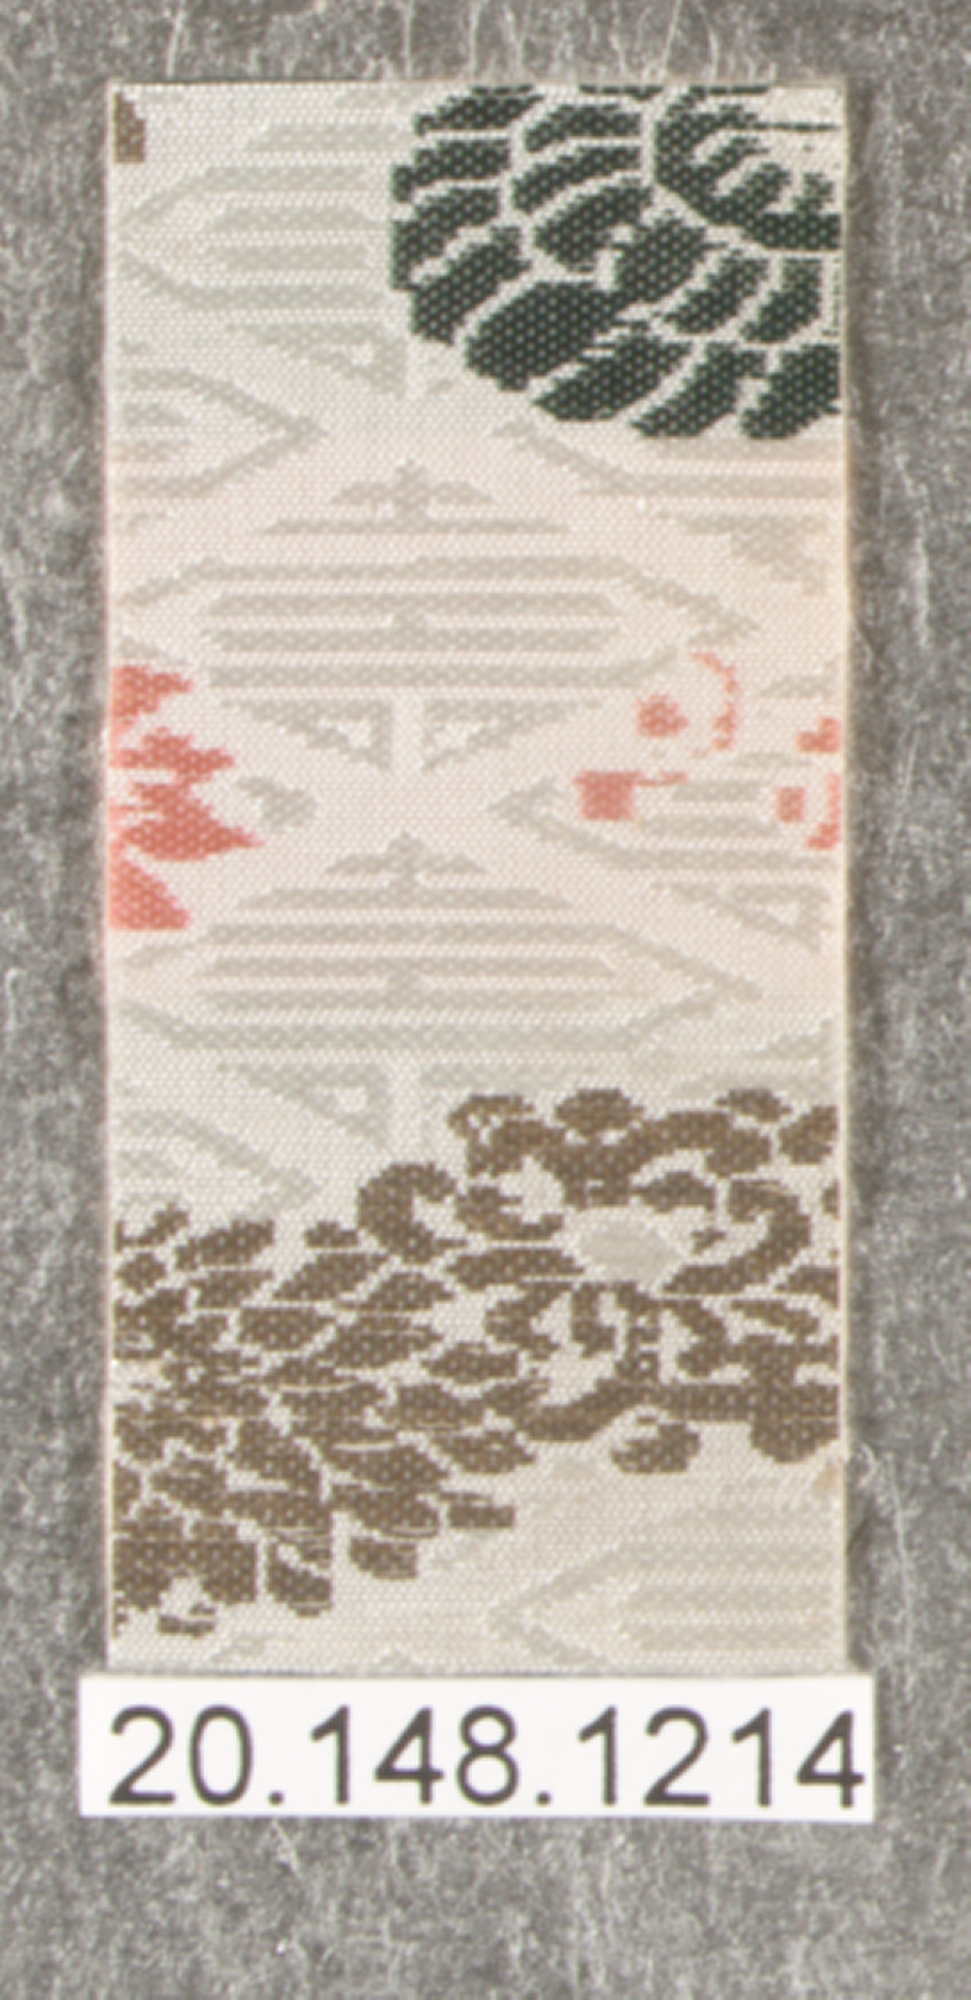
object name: piece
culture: japanese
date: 1801-1900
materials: silk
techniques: compound weave